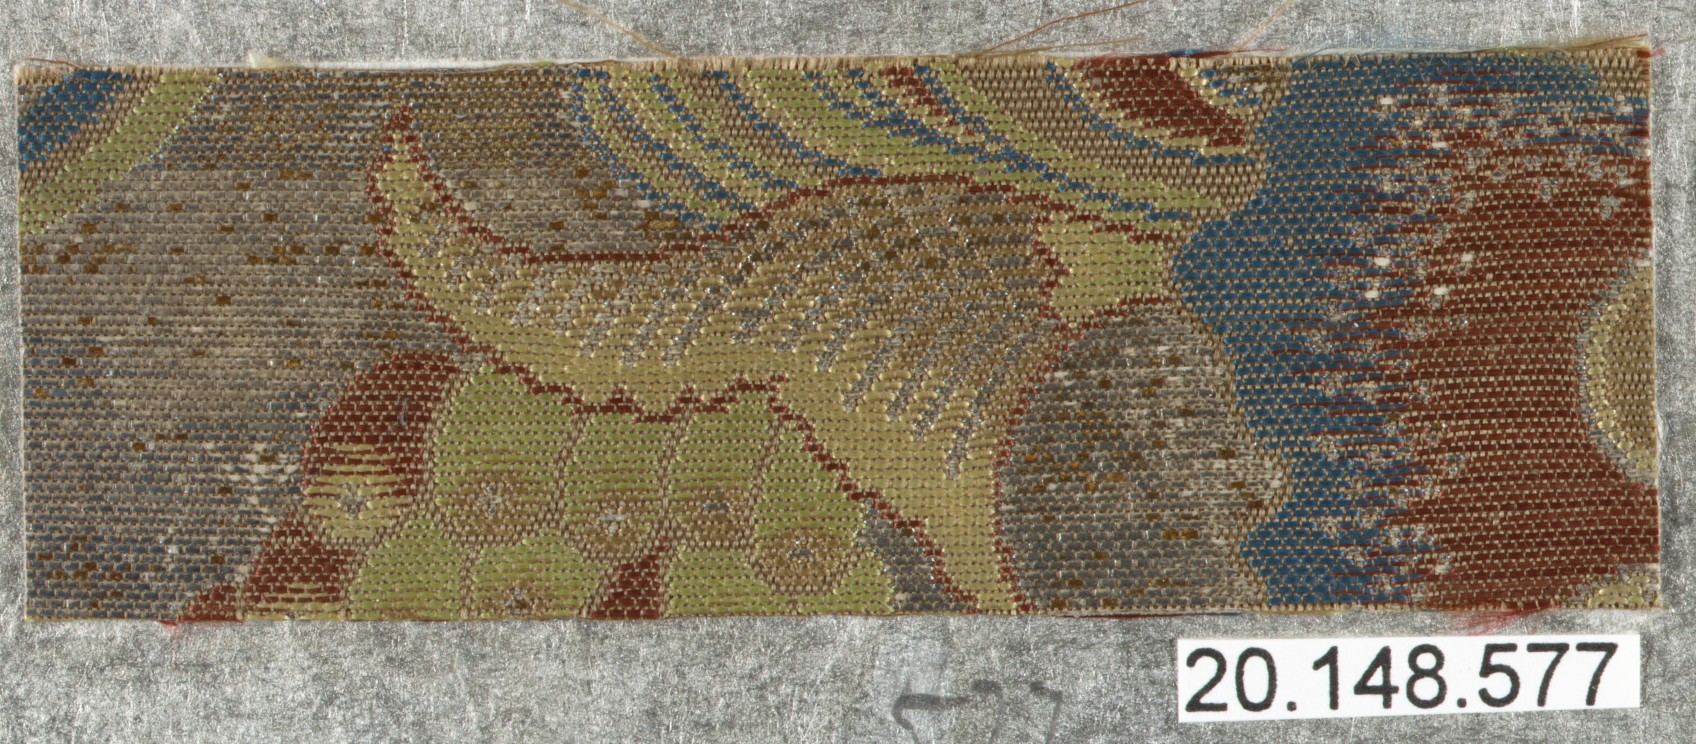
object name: piece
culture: japanese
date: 1701-1800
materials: silk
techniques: compound weave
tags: leaves